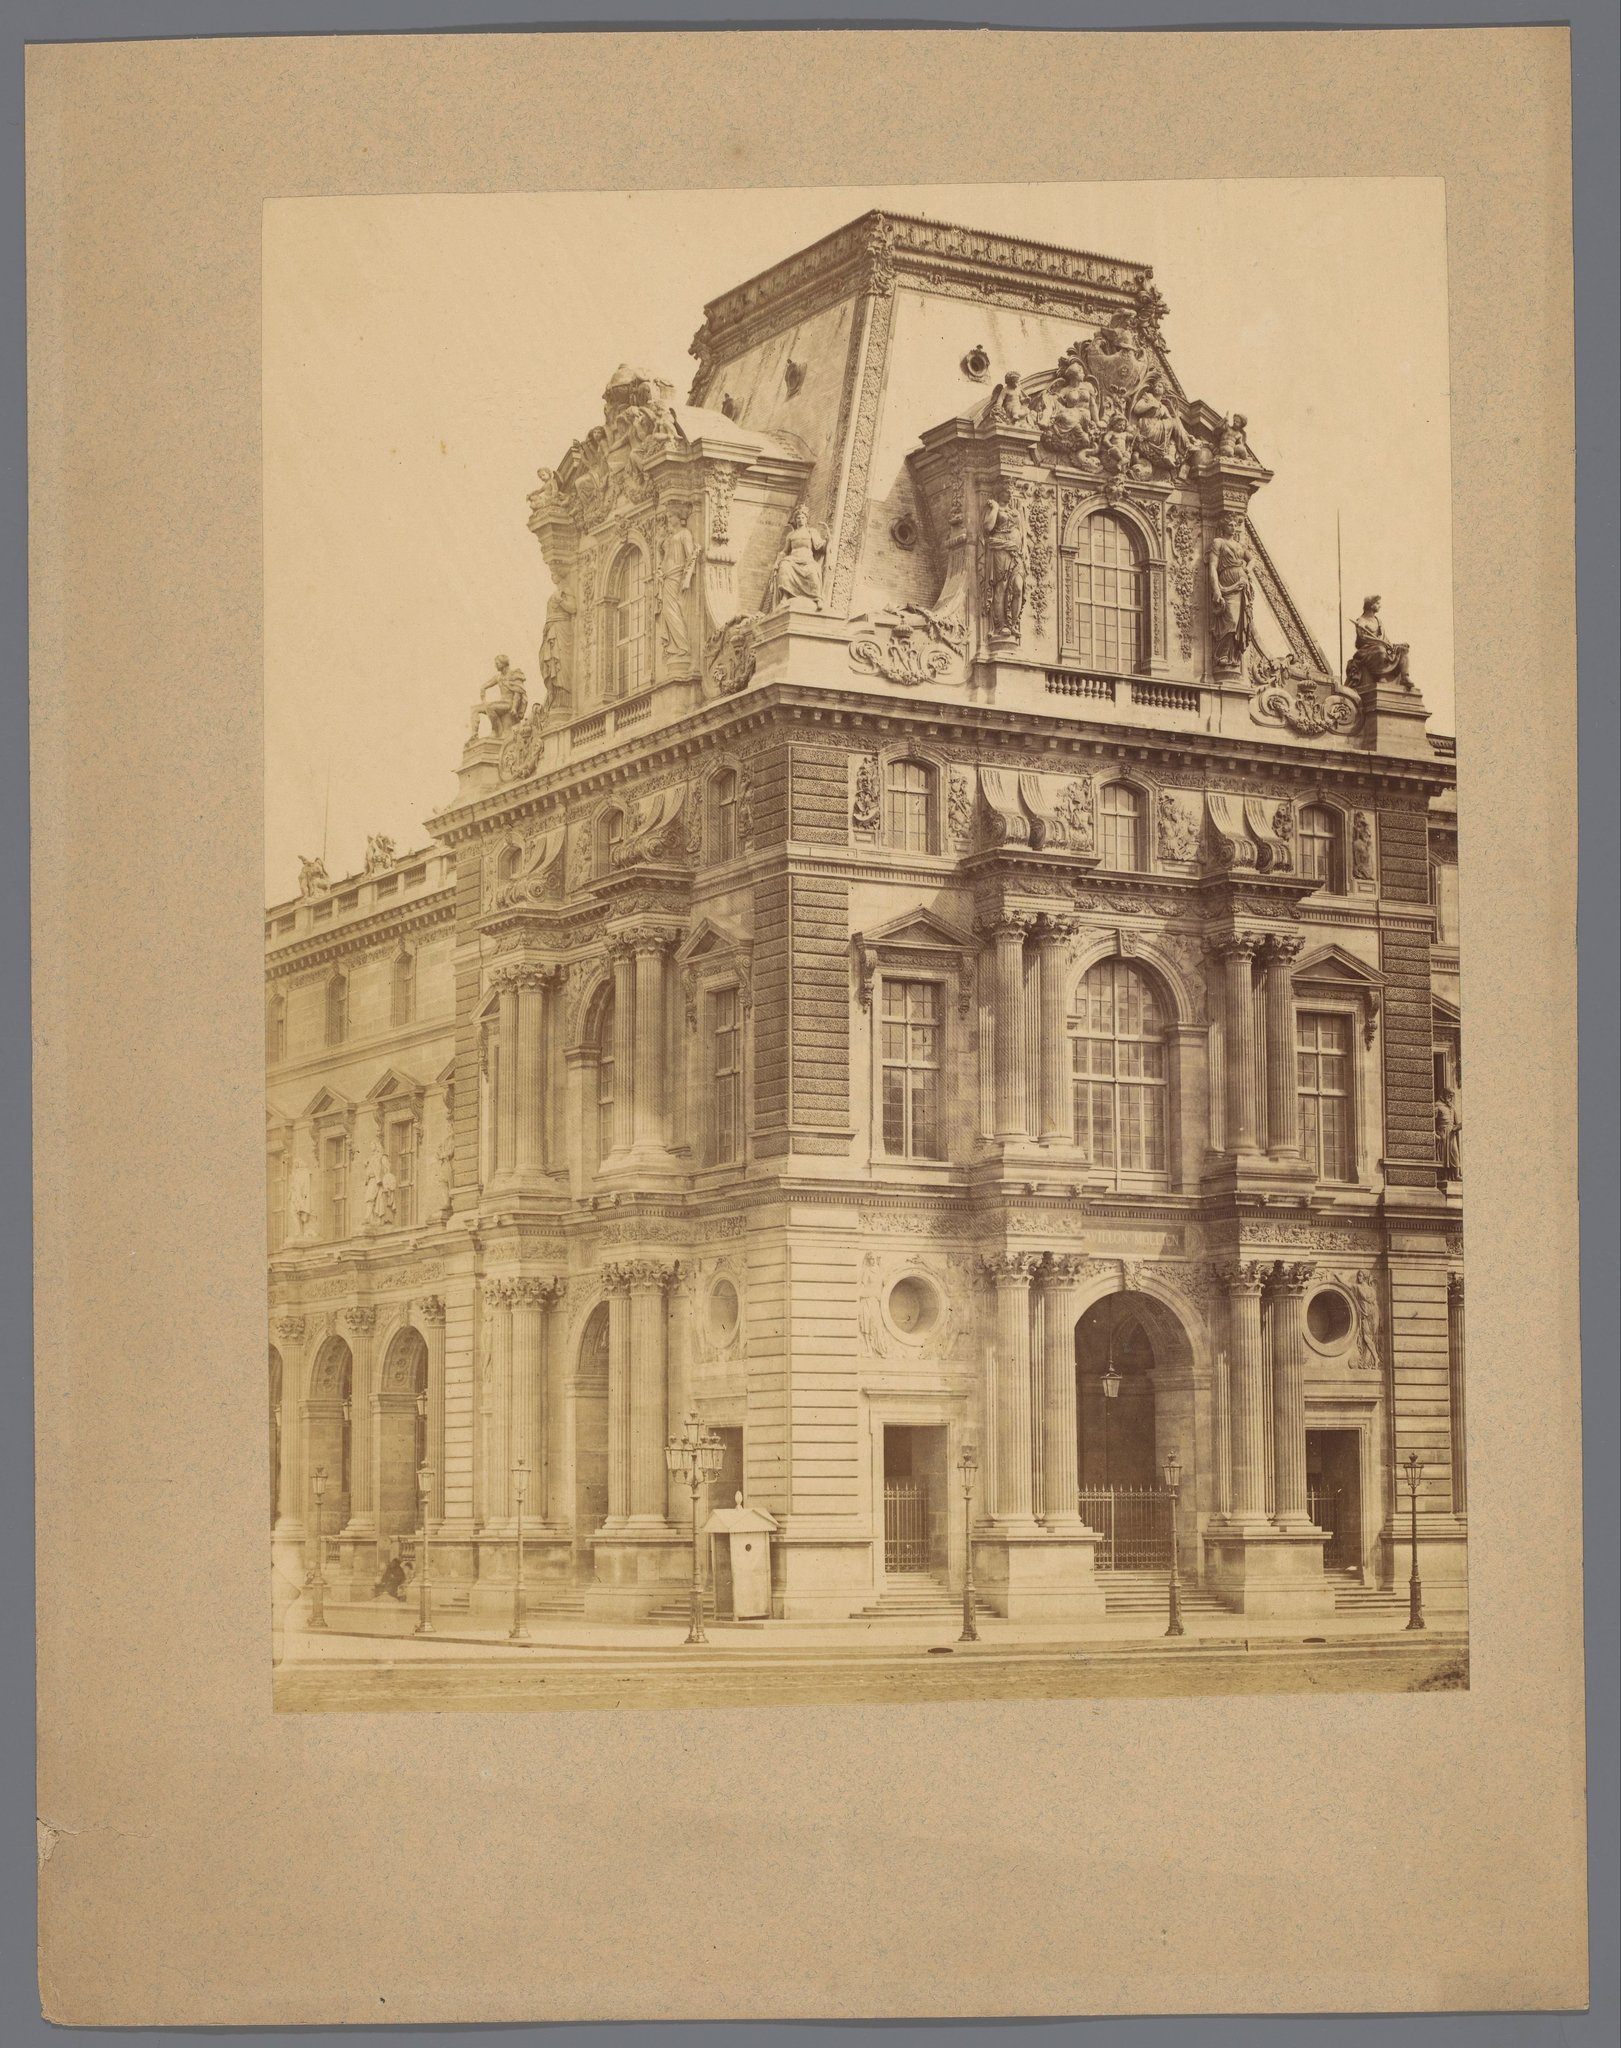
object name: photograph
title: Gezicht op het Pavillon Molien van het Louvre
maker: Anonymous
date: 1850-1900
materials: cardboard, photographic support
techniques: albumen print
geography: paris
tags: façade (of house or building)